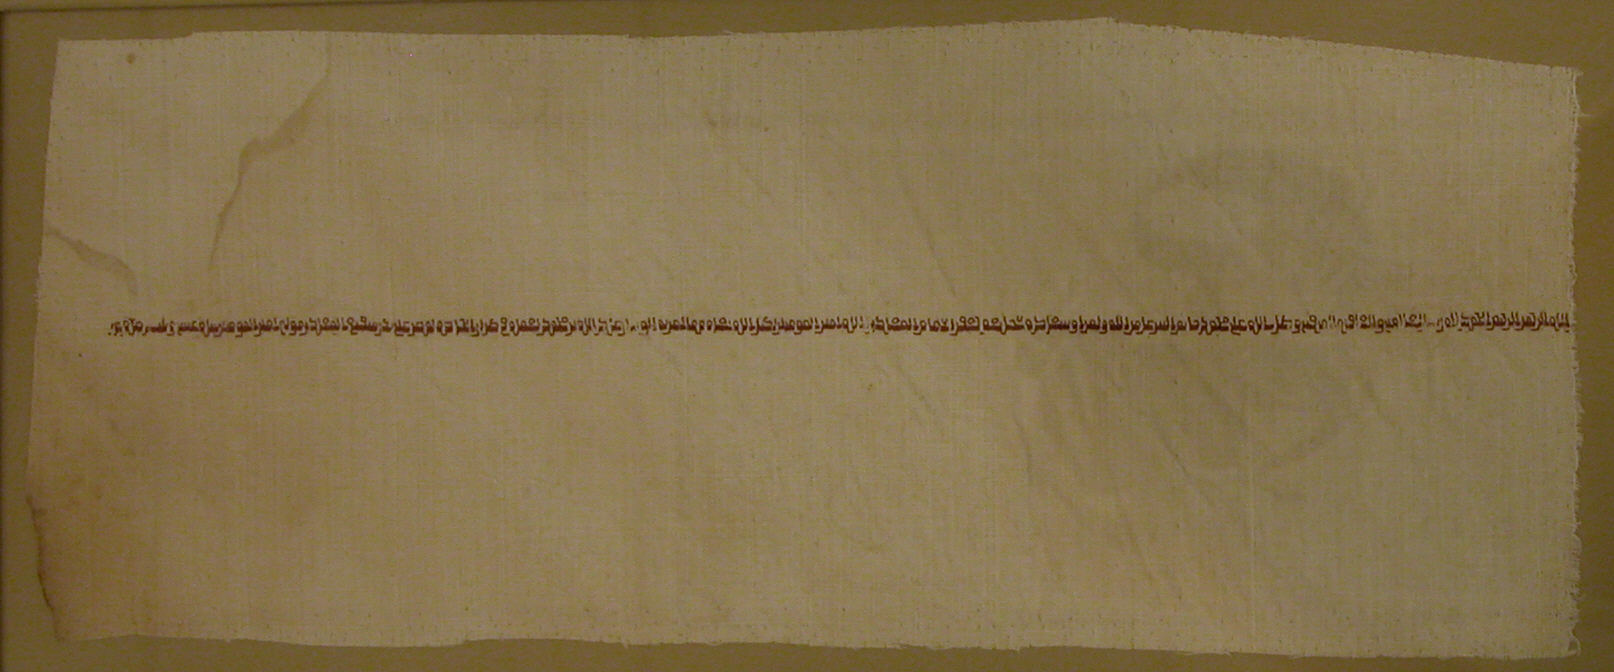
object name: textile fragment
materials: linen, silk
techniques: embroidery, weave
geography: egypt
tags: arabic